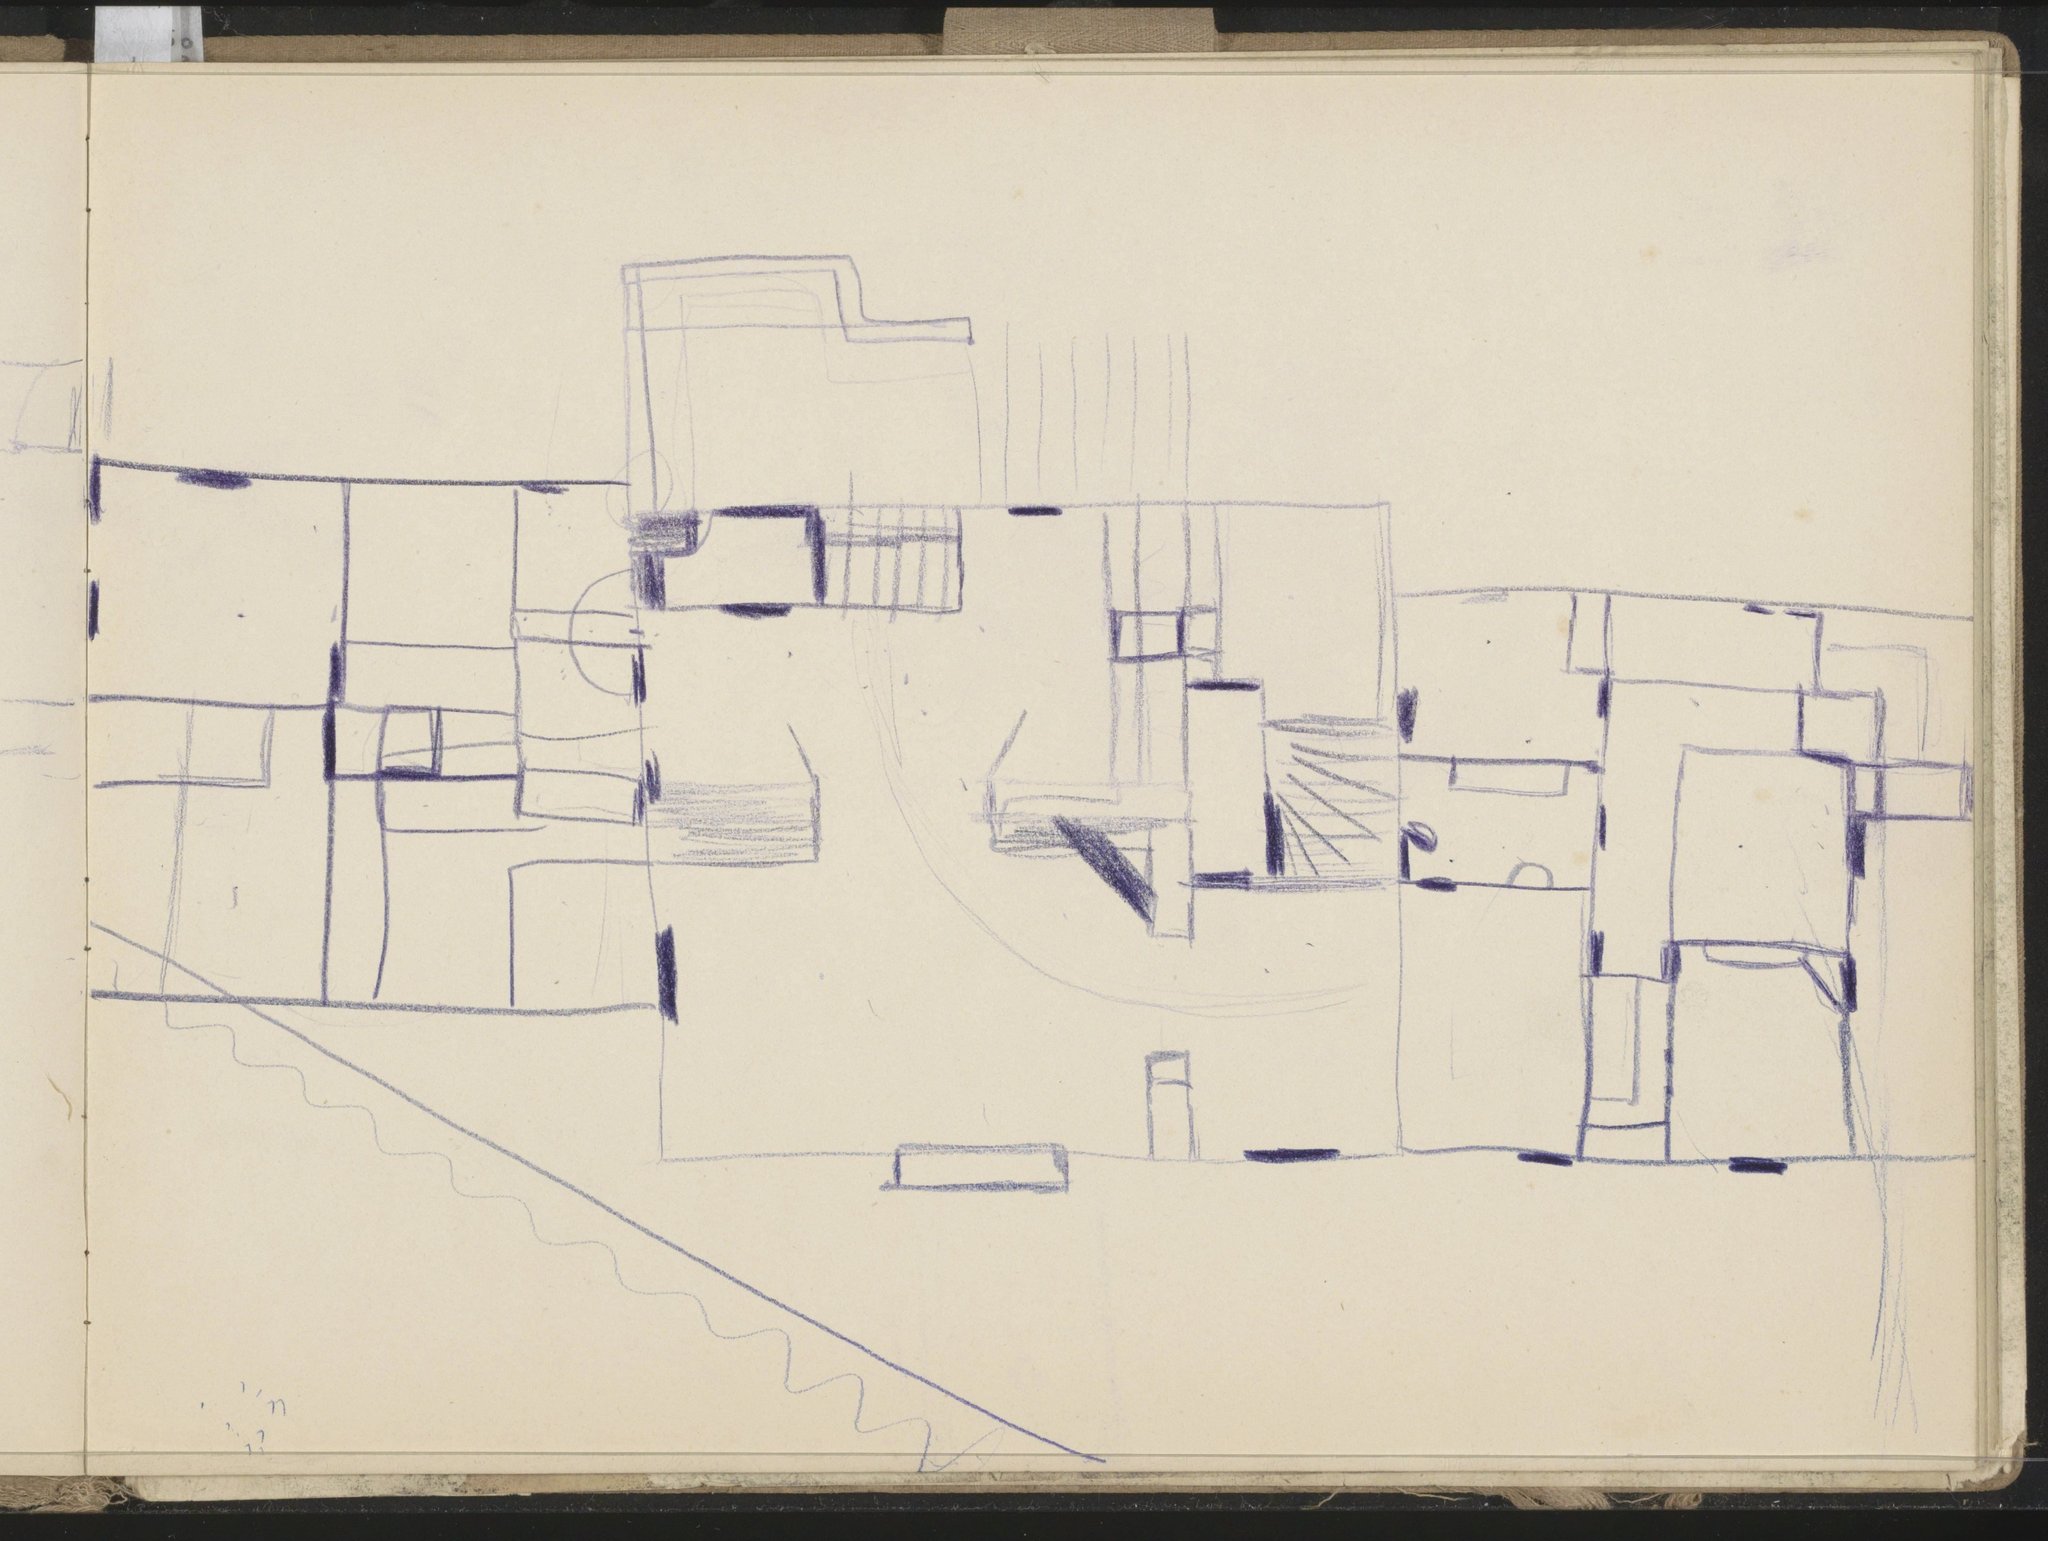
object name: sketchbook leaf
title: Plattegrond van een woning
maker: willem bastiaan tholen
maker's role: draughtsman, painter, print maker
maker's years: 1860-1931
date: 1870-1931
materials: paper, pencil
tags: plan ~ architecture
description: Blad 9 recto uit een schetsboek met 22 bladen.